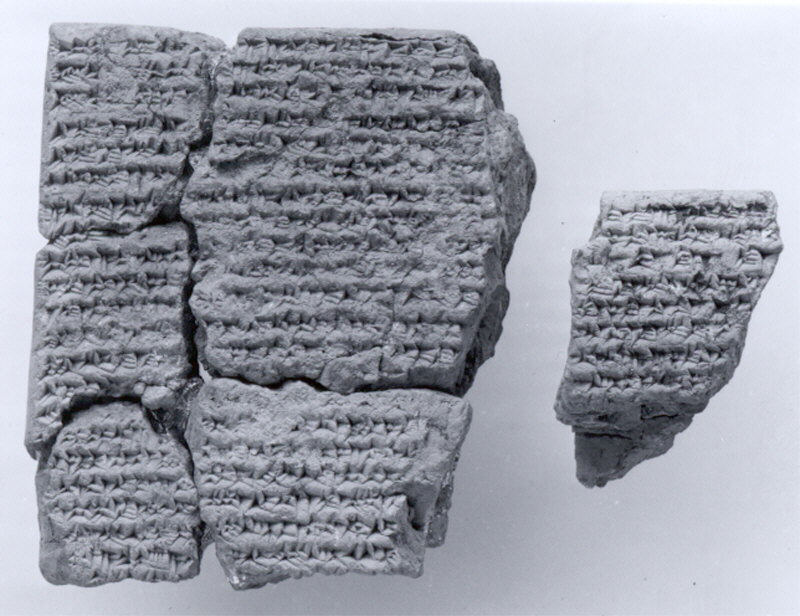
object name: cuneiform tablet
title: Cuneiform tablet: fragment of a ritual text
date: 333-1 BCE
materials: clay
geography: mesopotamia